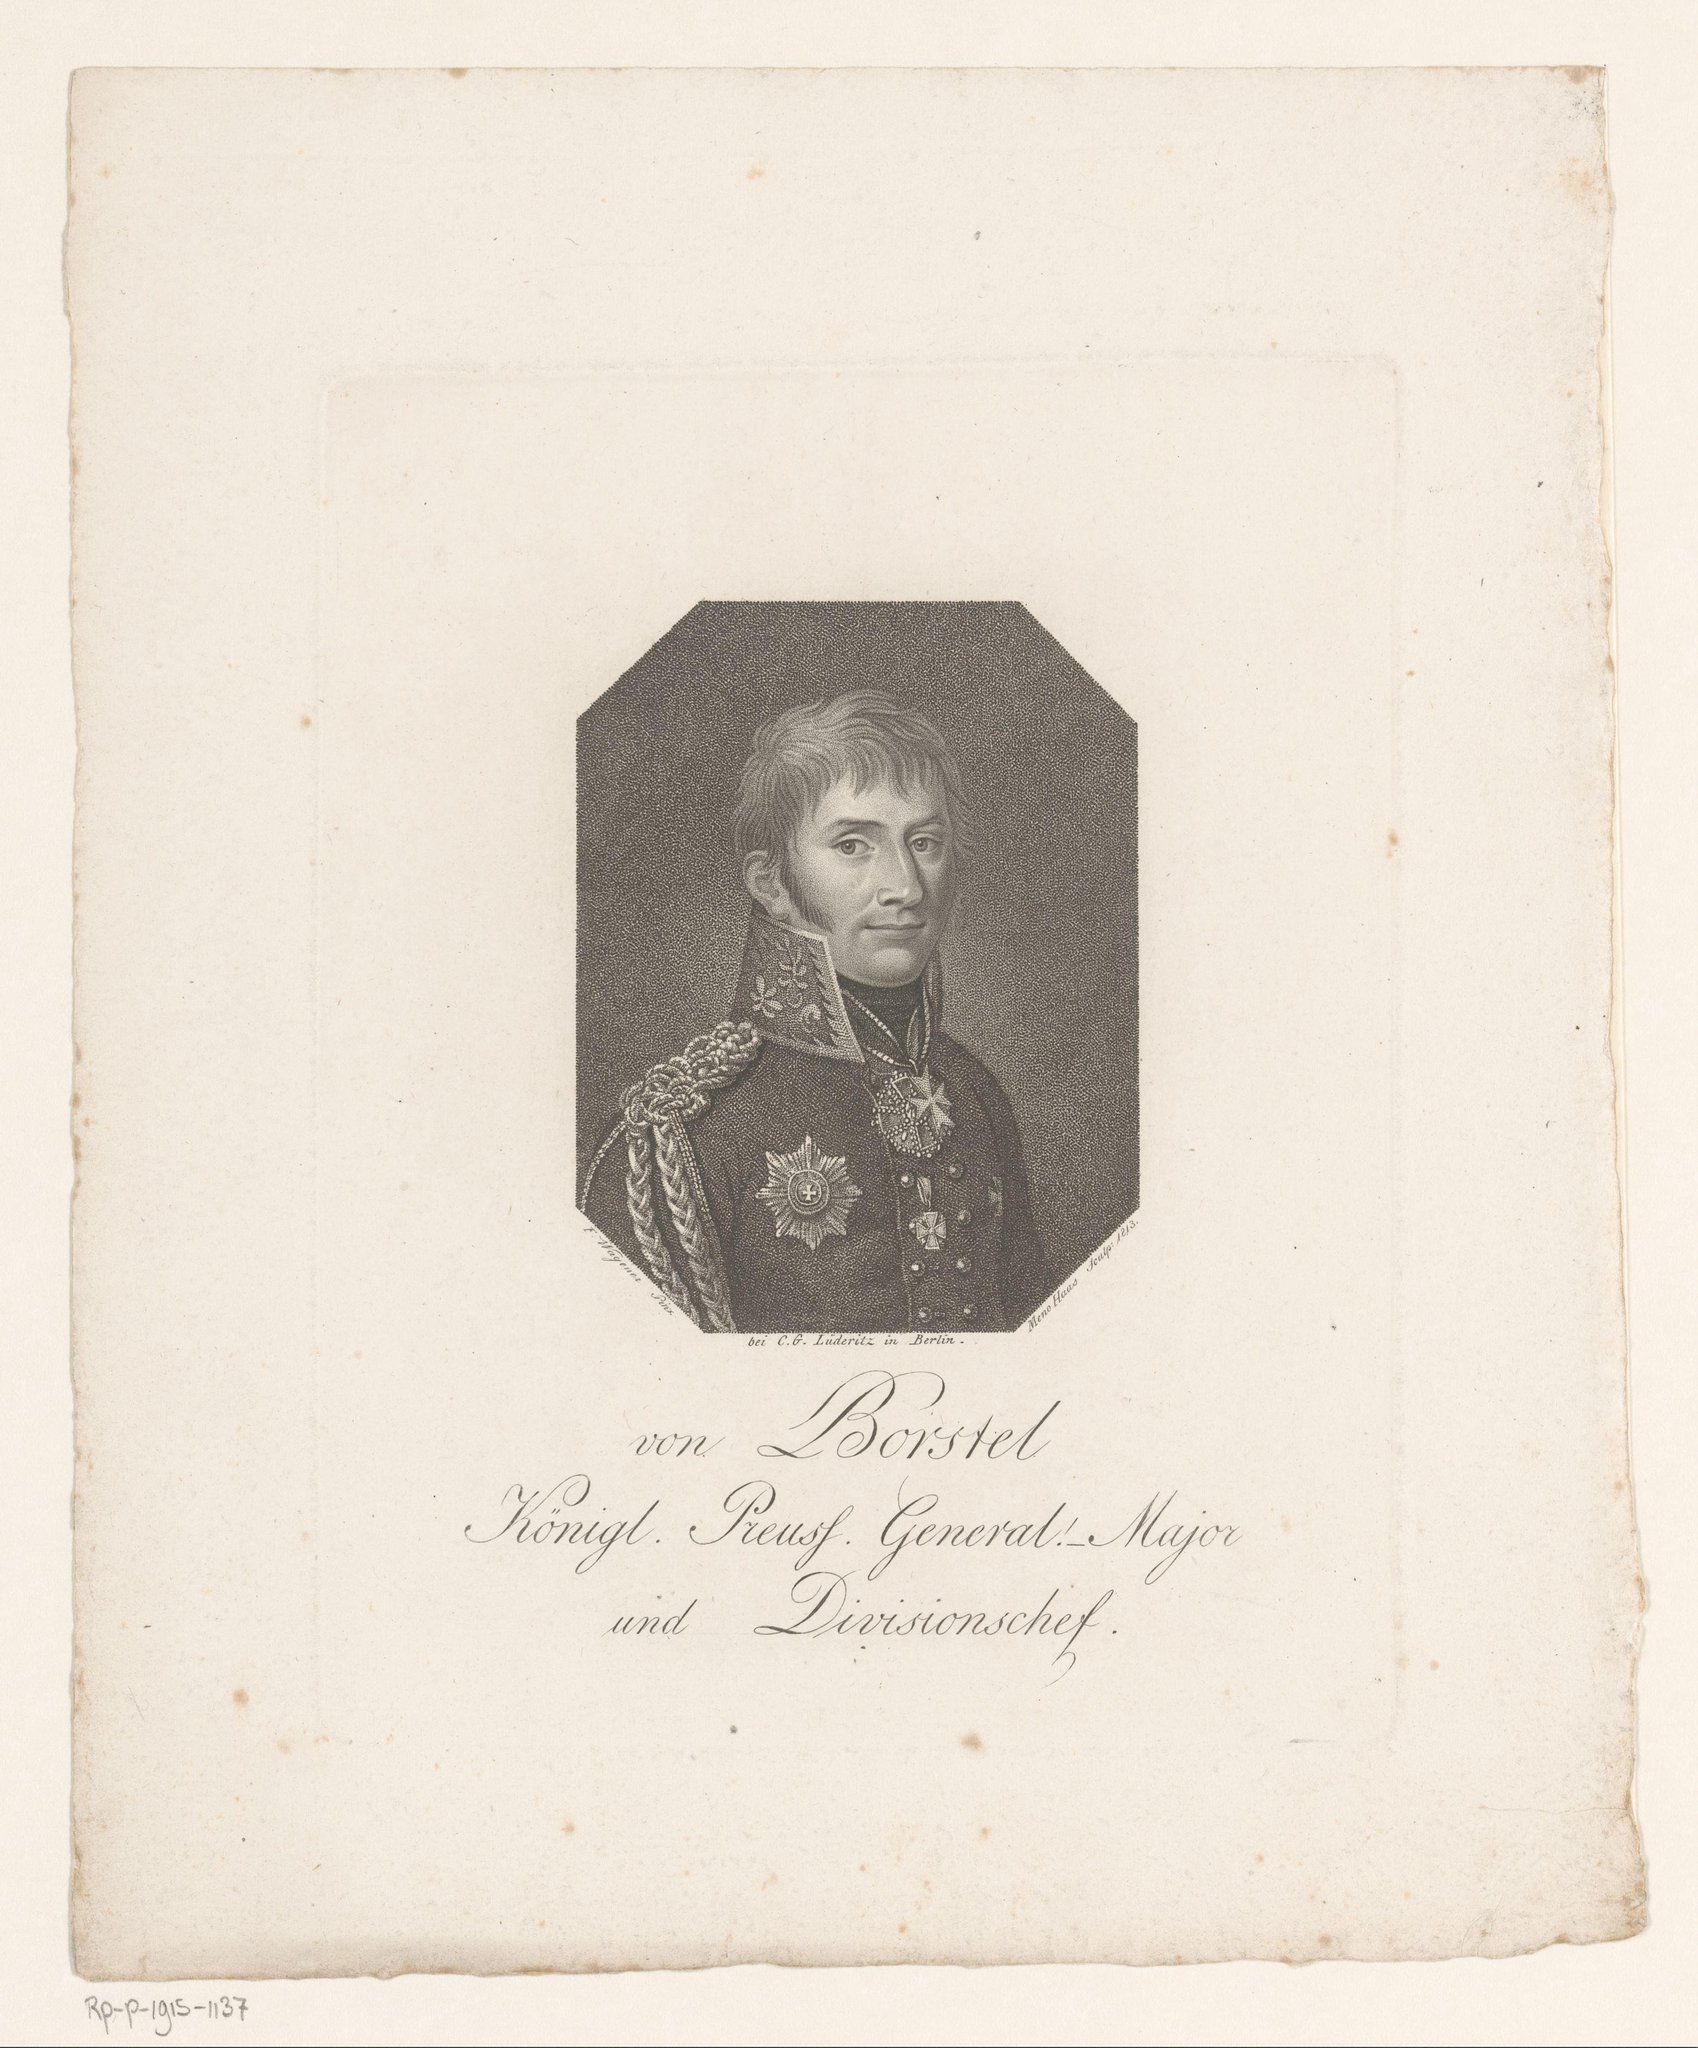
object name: print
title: Portret van Ludwig von Borstell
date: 1813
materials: paper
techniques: stippling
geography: berlin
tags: berlin, knighthood order, historical persons, medals and other marks of military honour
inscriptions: collector's mark: Lugt 2233